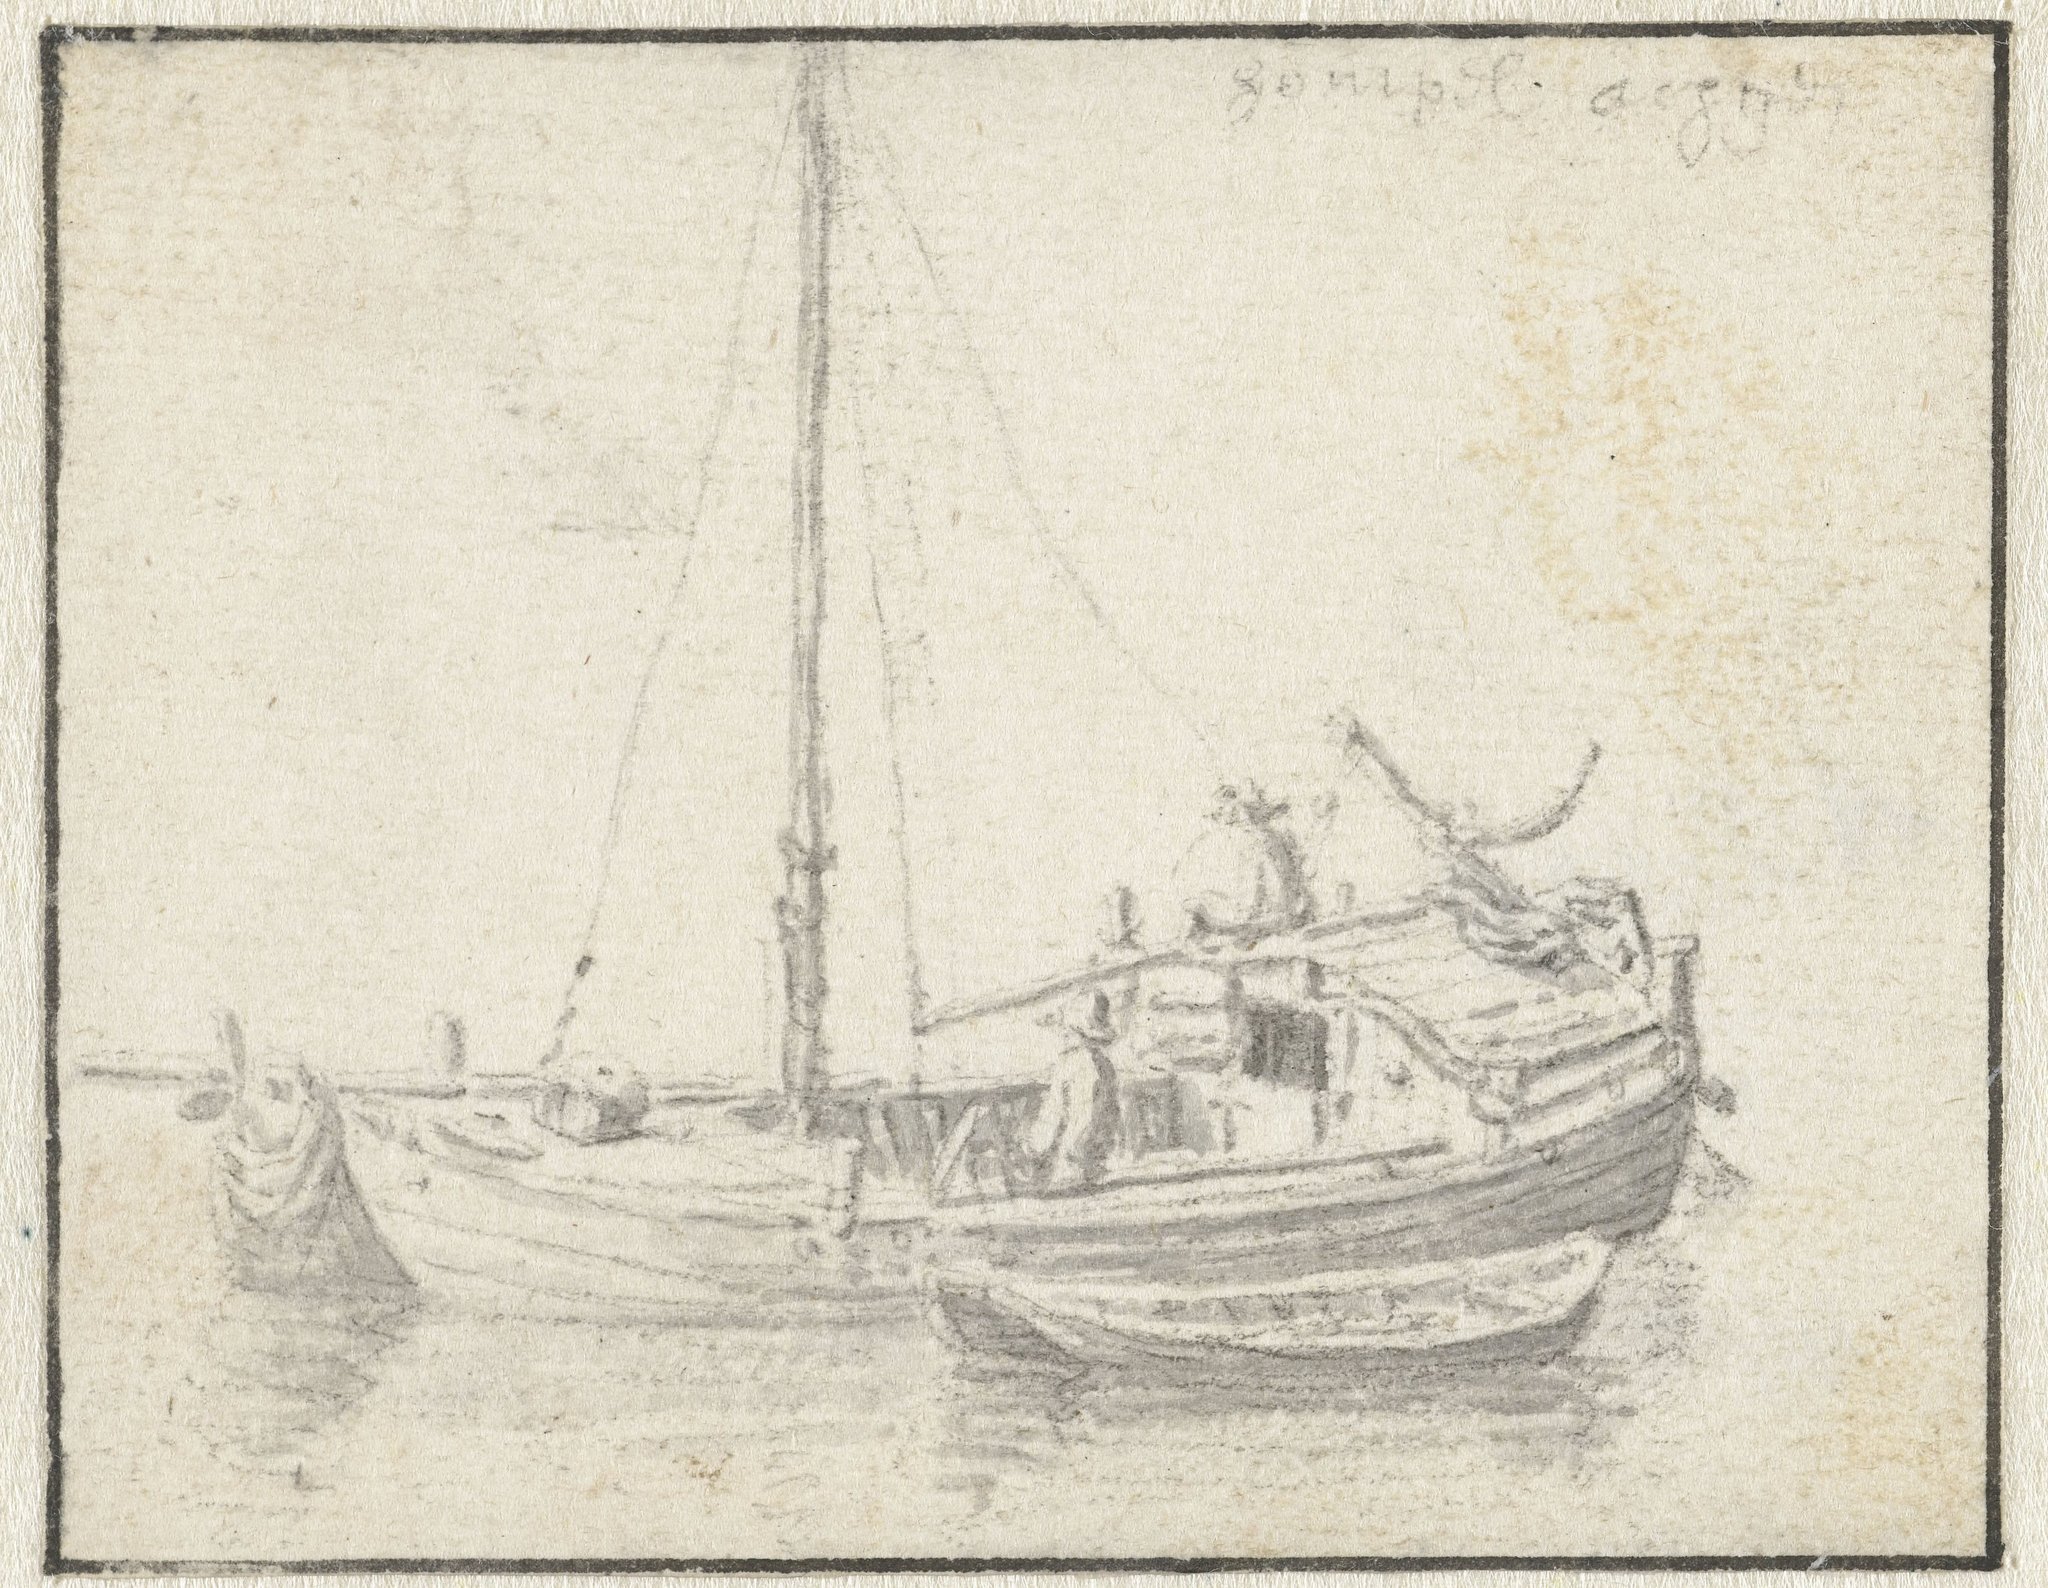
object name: drawing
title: Schuit met een roeiboot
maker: herman saftleven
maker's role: draughtsman, painter, print maker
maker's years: 1609-1685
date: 1619-1685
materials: chalk, paper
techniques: brush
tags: sailing-ship, sailing-boat (+ rest ~ travelling), rowing-boat, canoe, etc. (+ rest ~ travelling)